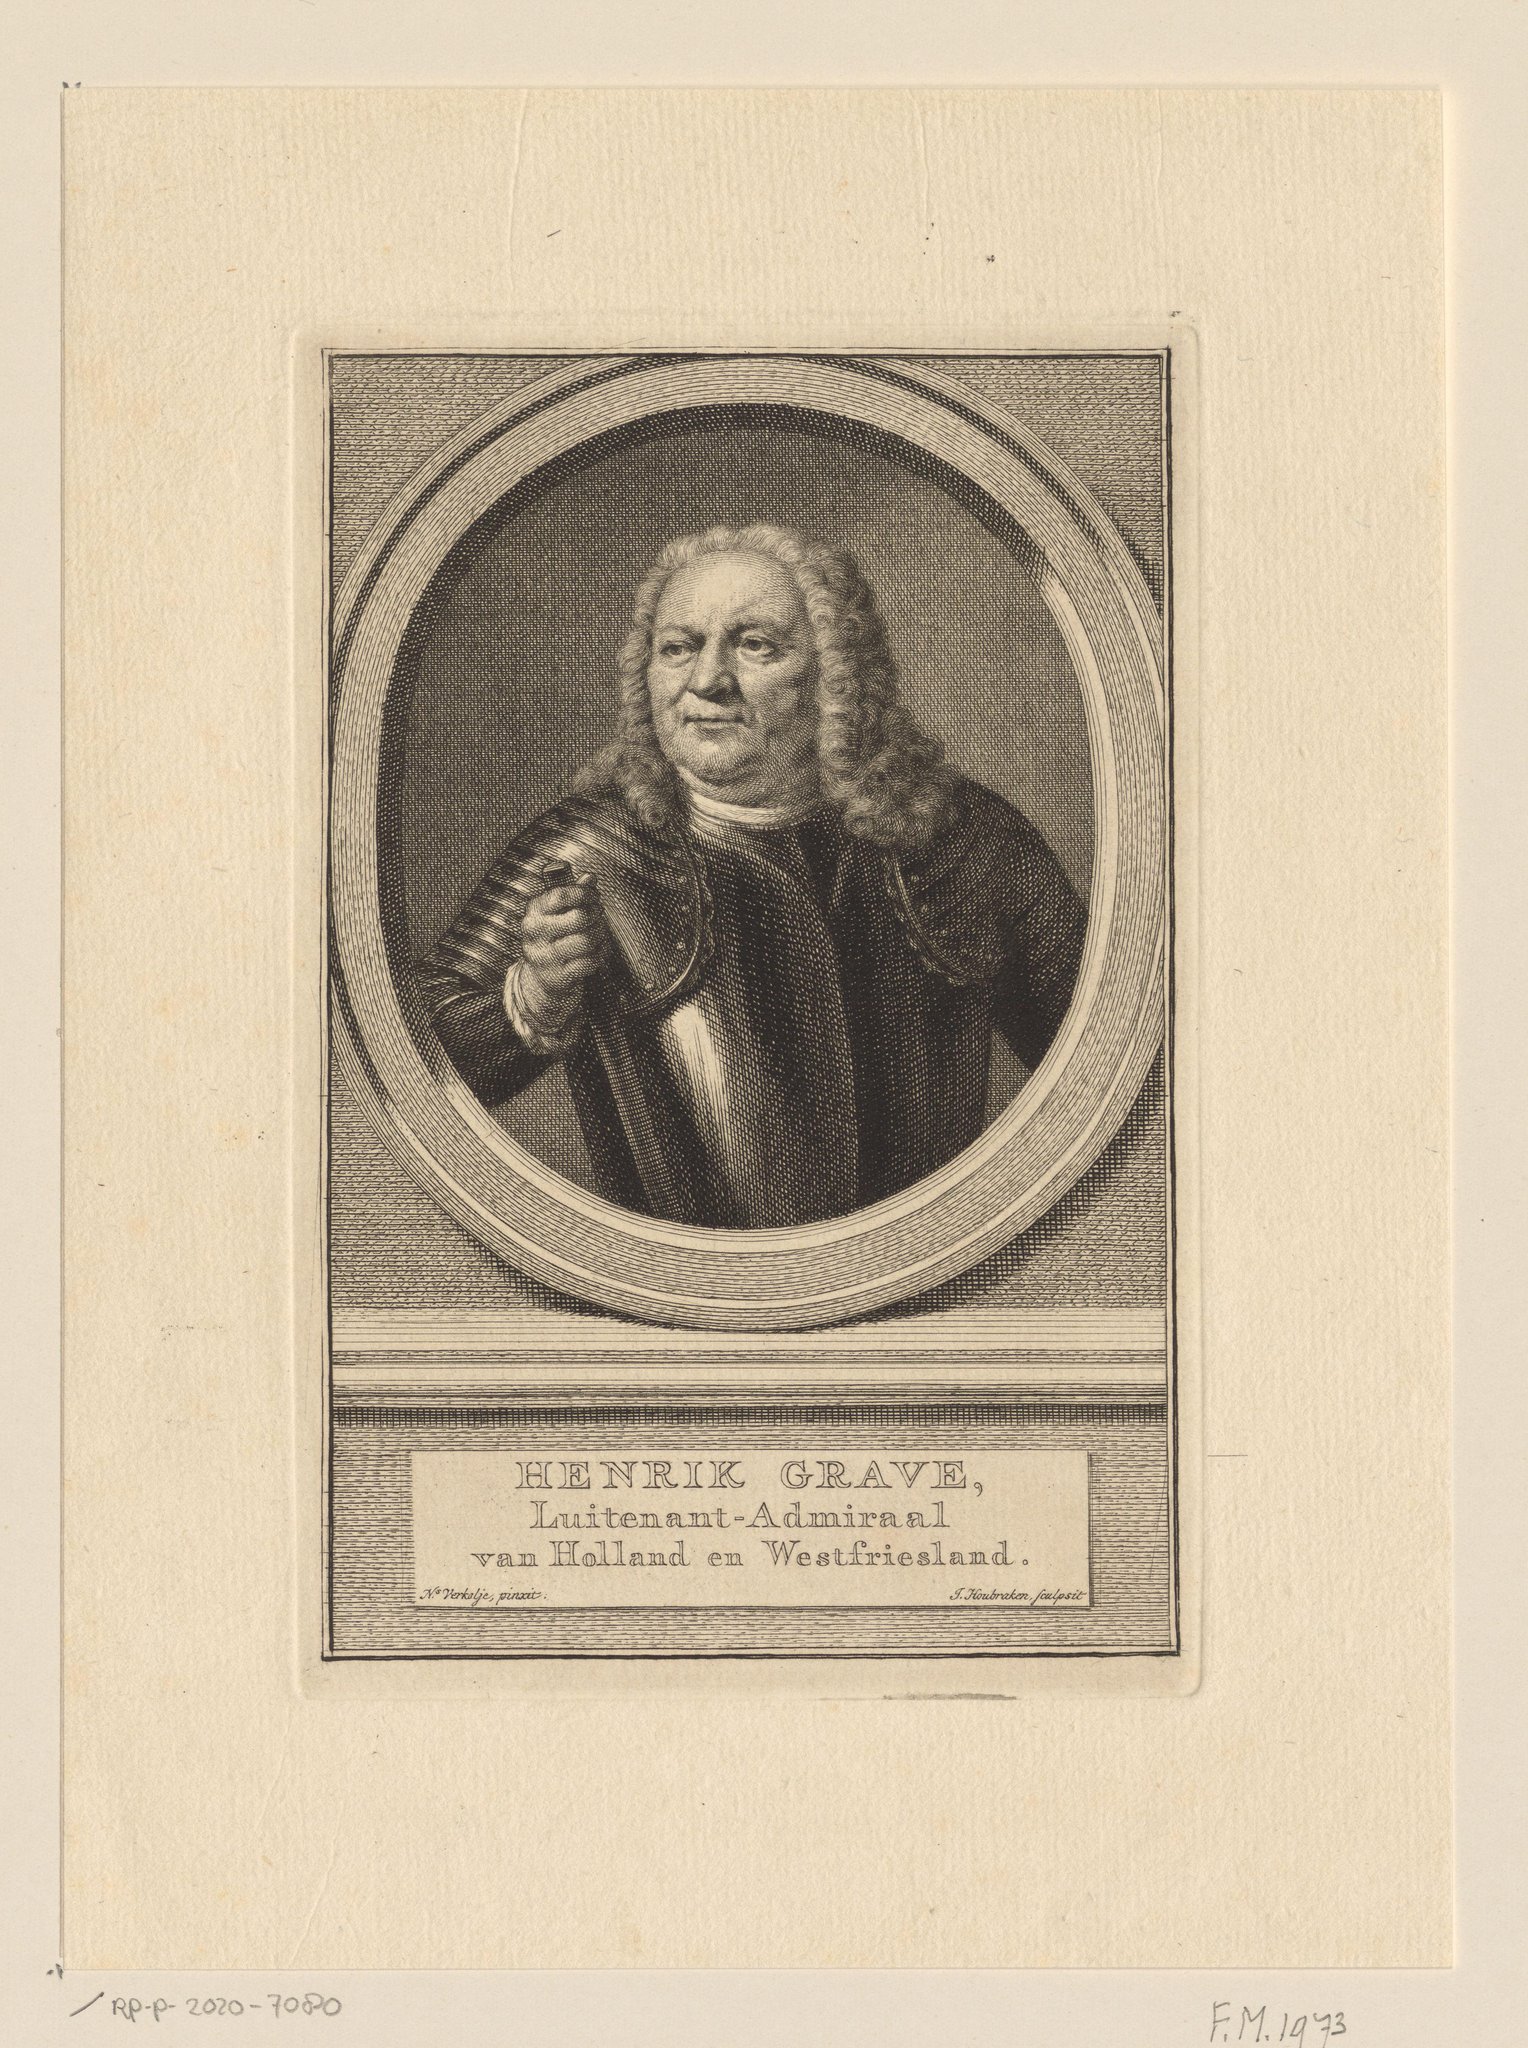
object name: book illustration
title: Portret van Hendrik Gravé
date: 1770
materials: paper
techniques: engraving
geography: amsterdam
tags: amsterdam, commander-in-chief, general, marshal, historical persons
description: Prent uit: Wagenaar, Jan. Vaderlandsche historie, vervattende de geschiedenissen der nu Vereenigde Nederlanden, inzonderheid die van Holland (...). Amsterdam: weduwe Isaak Tirion, 1770, dl. 1, p. 338. Eerdere staat gebruikt in: Jan Wagenaar, Vaderlandsche historie, vervattende de geschiedenissen der nu Vereenigde Nederlanden, inzonderheid die van Holland (...). 21 dln. Amsterdam, Isaak Tirion, 1749-1759.